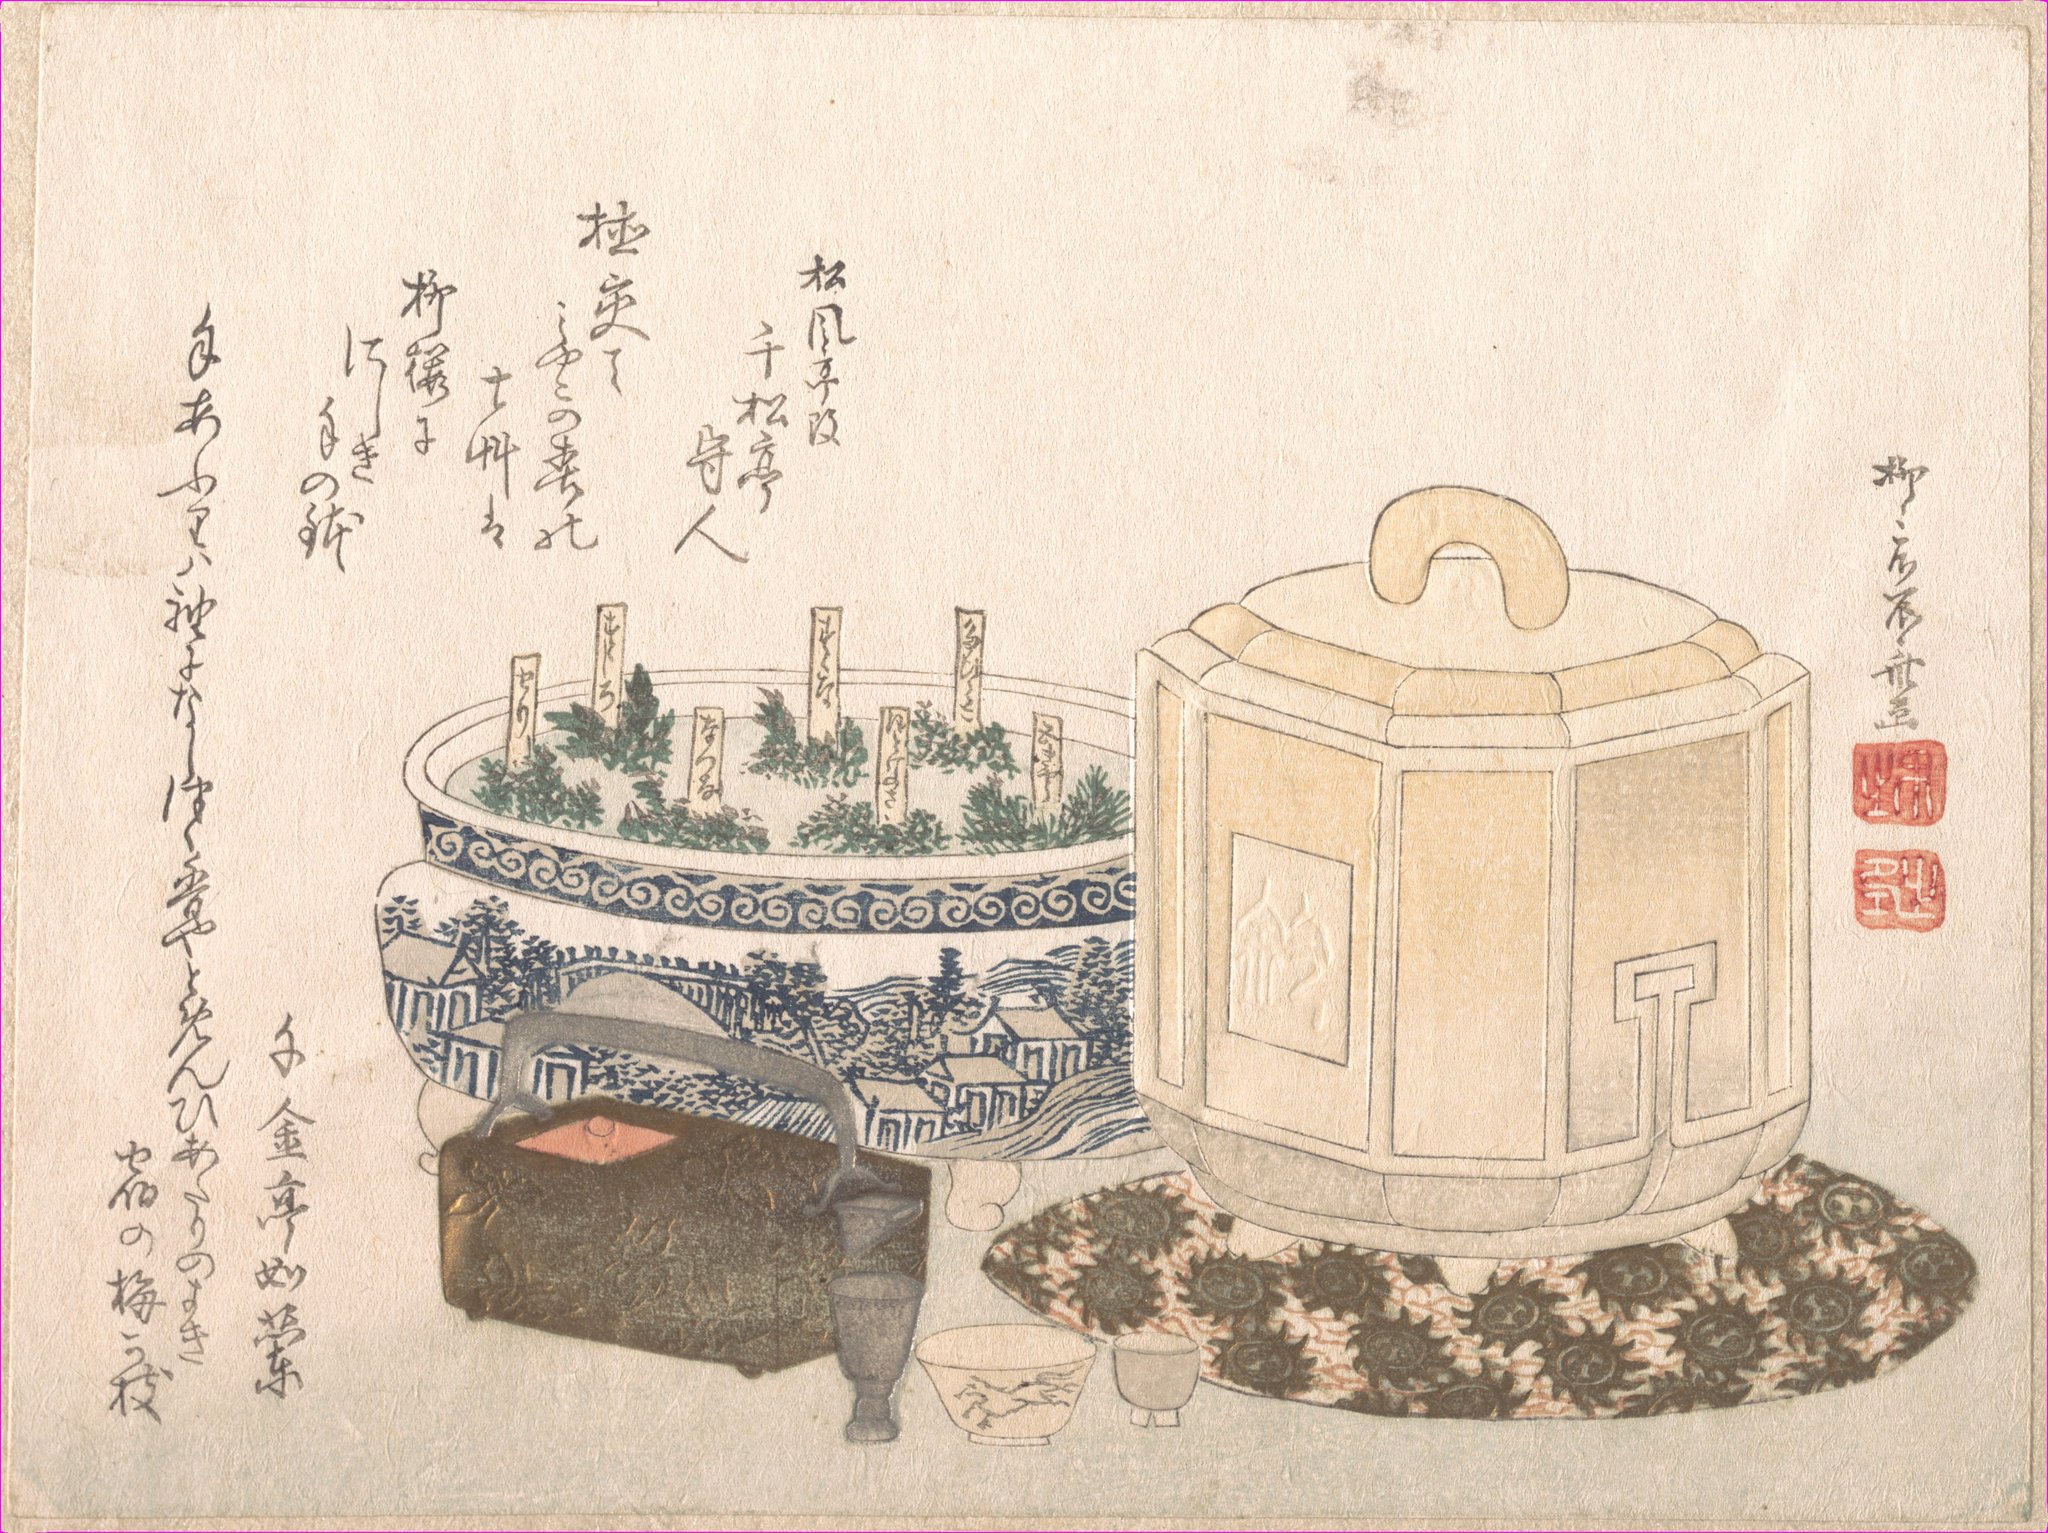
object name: print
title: Fire-Holder and Flower-Pot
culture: japanese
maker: ryūryūkyo shinsai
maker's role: artist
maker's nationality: japanese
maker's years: 1799-1823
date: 1801-1900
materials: ink, paper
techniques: surimono, woodblock print